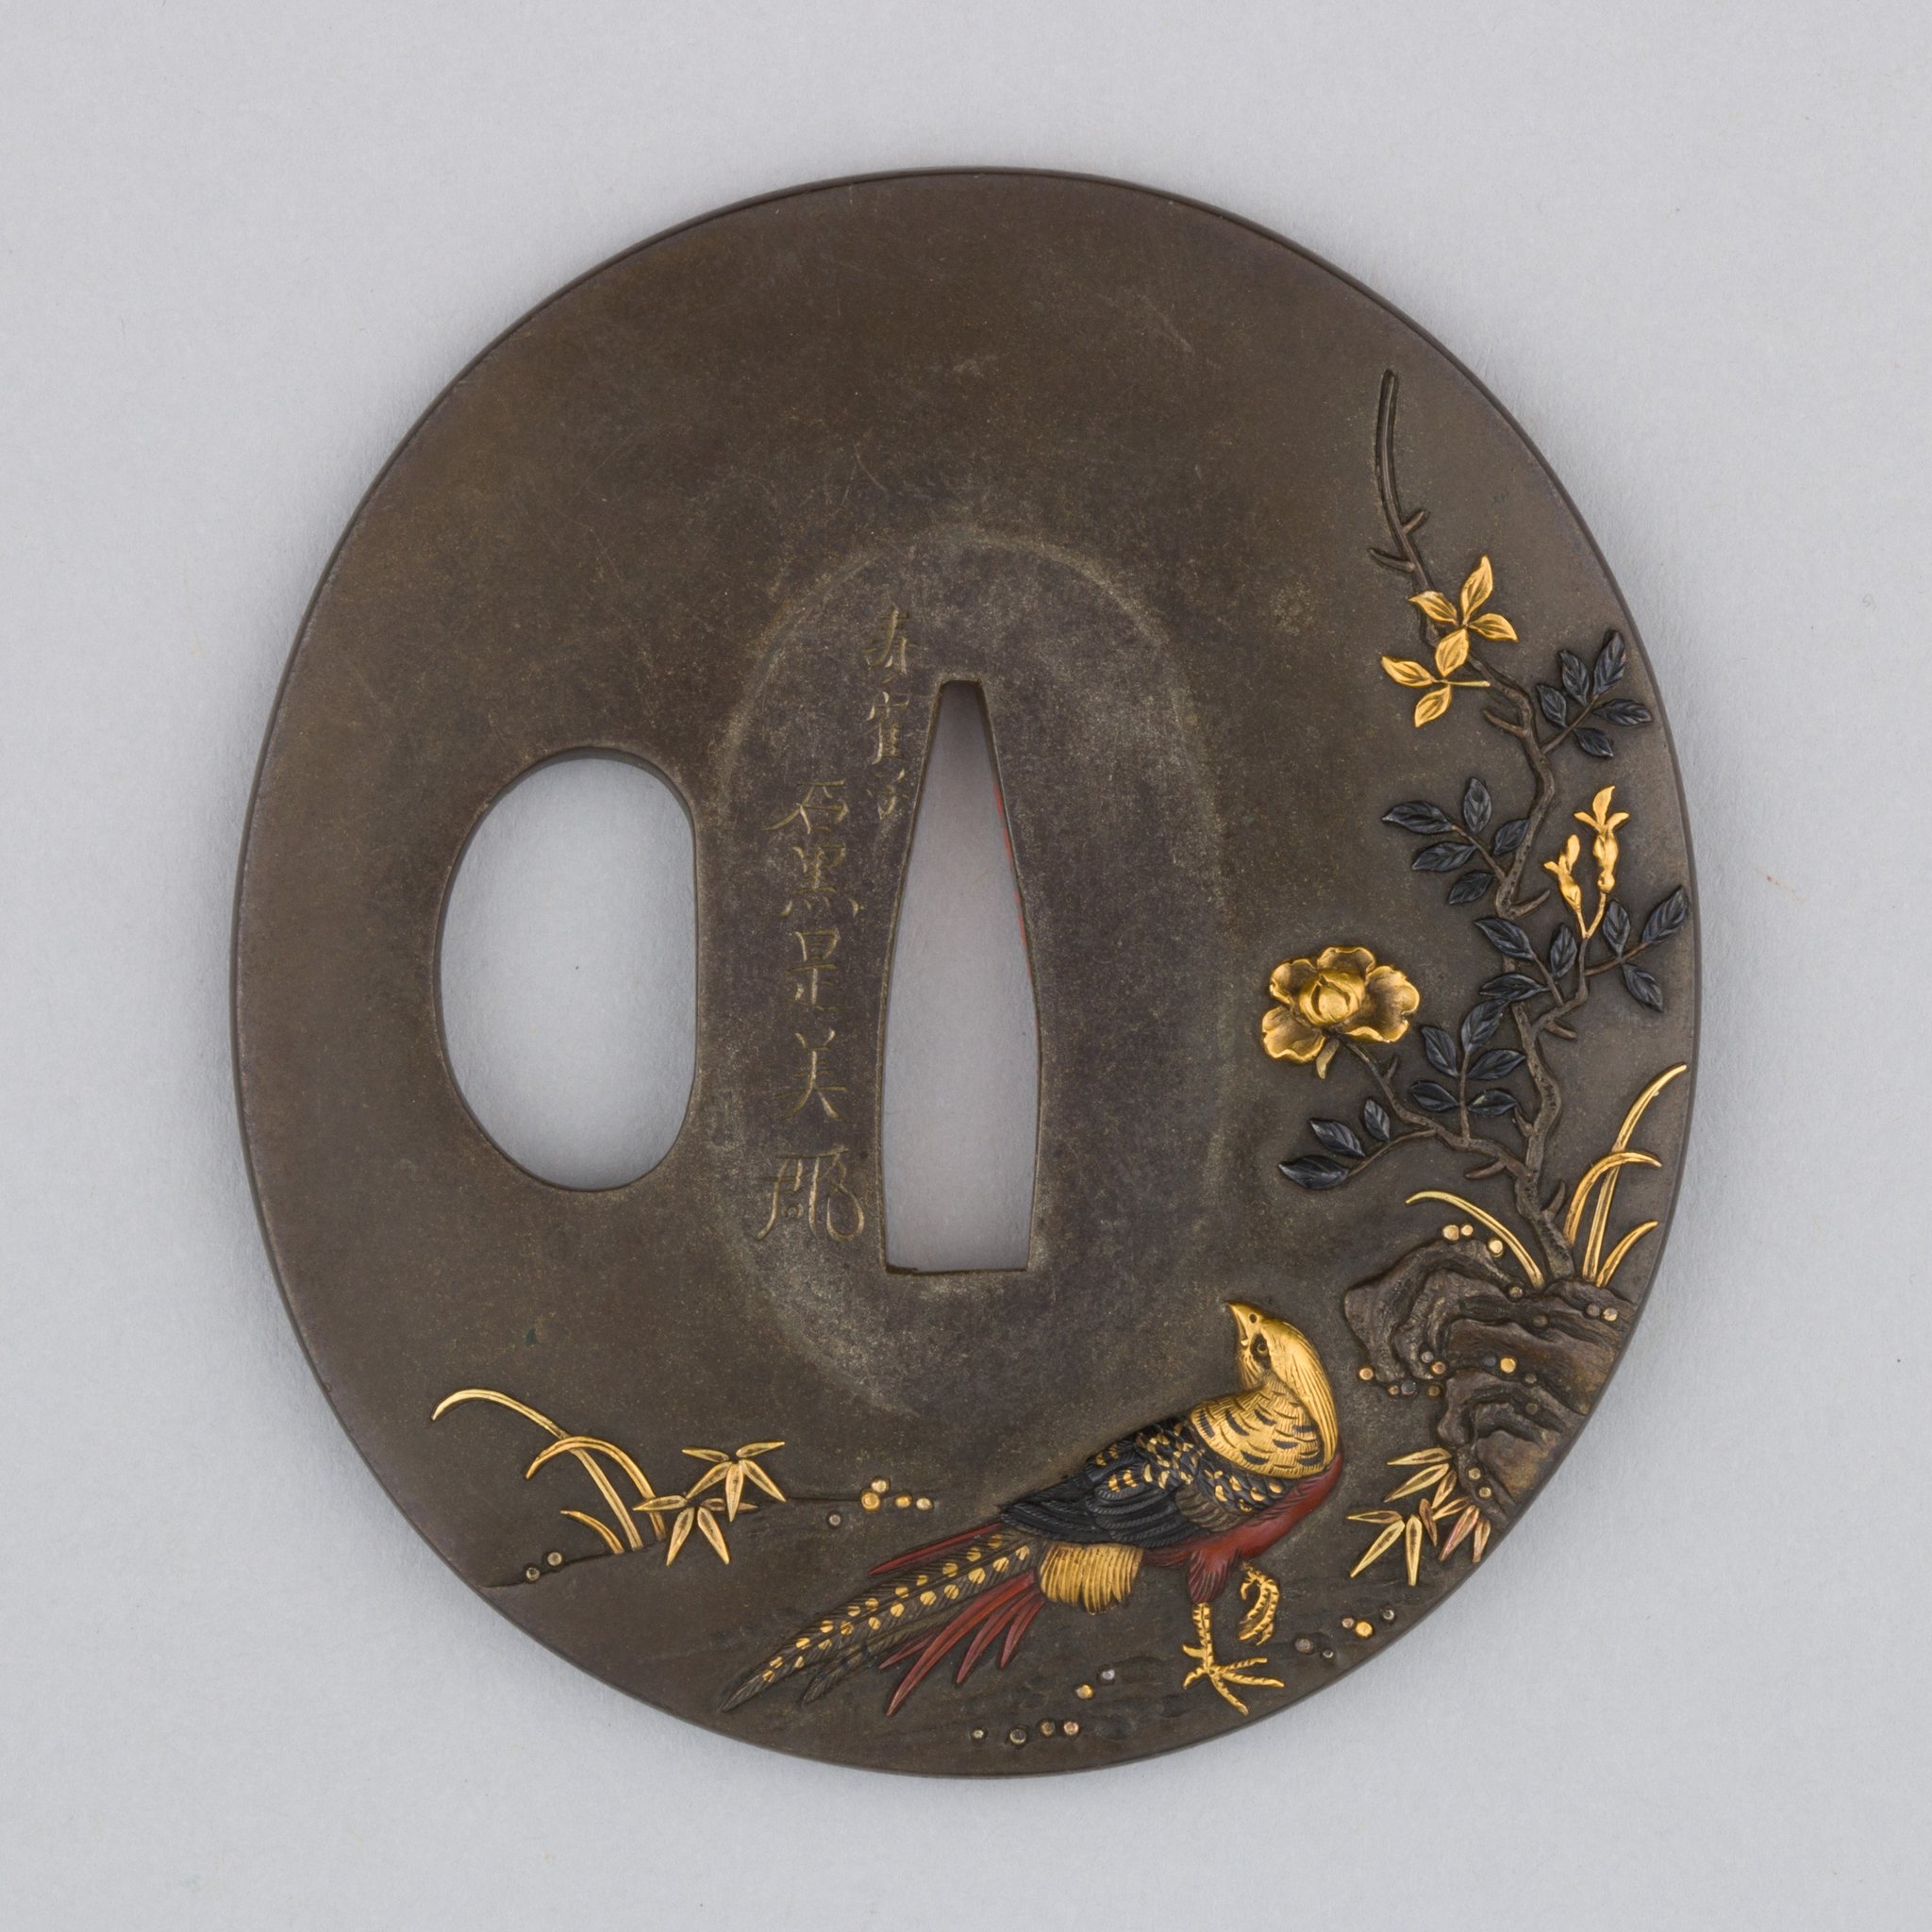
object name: sword guard tsuba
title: Sword Guard (Tsuba)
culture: japanese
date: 1615-1868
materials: copper, gold alloy, gold, silver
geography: japan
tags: birds,flowers,leaves